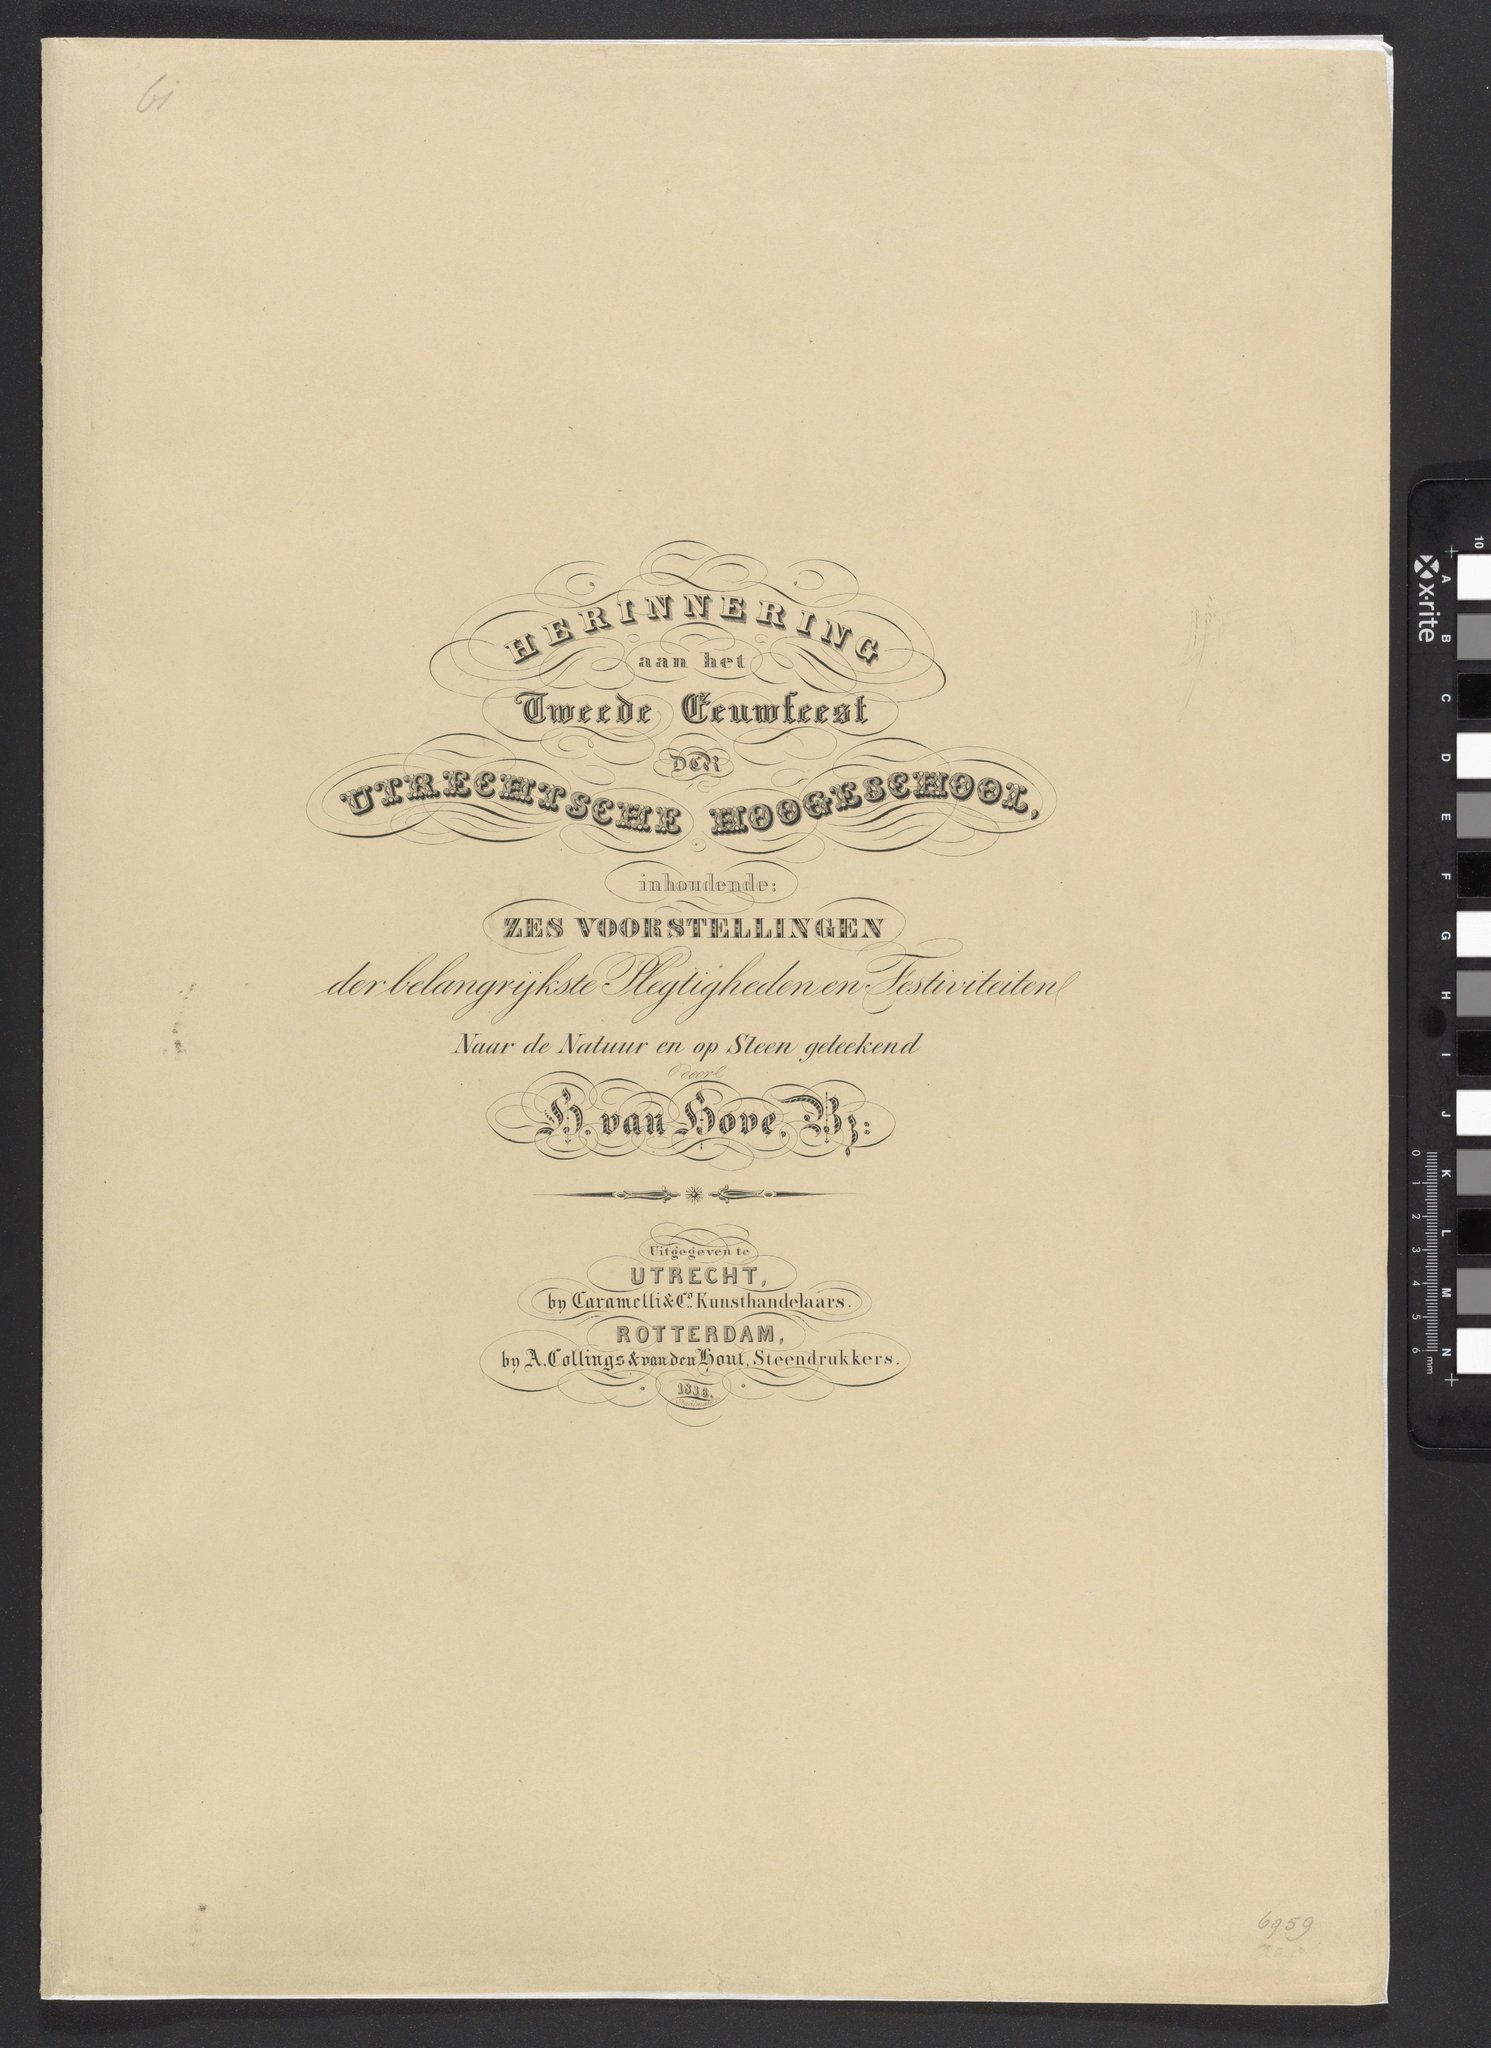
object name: print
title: Herinnering aan het Tweede Eeuwfeest der Utrechtsche Hoogeschool, inhoudende: zes voorstellingen der belangrijkste Plegtigheden en Festiviteiten [1836]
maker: ph.r. stadlmair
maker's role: lithograaf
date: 1836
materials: paper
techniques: lithograph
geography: utrecht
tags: universiteit utrecht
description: Omslag met een gedrukte verklaring, een titelplaat en zes ongenummerde platen van de feestelijkheden bij de viering van het tweede eeuwfeest (1636-1836) van de Utrechtsche Hogeschool, 12-17 juni 1836. Omslag met typografische titel.